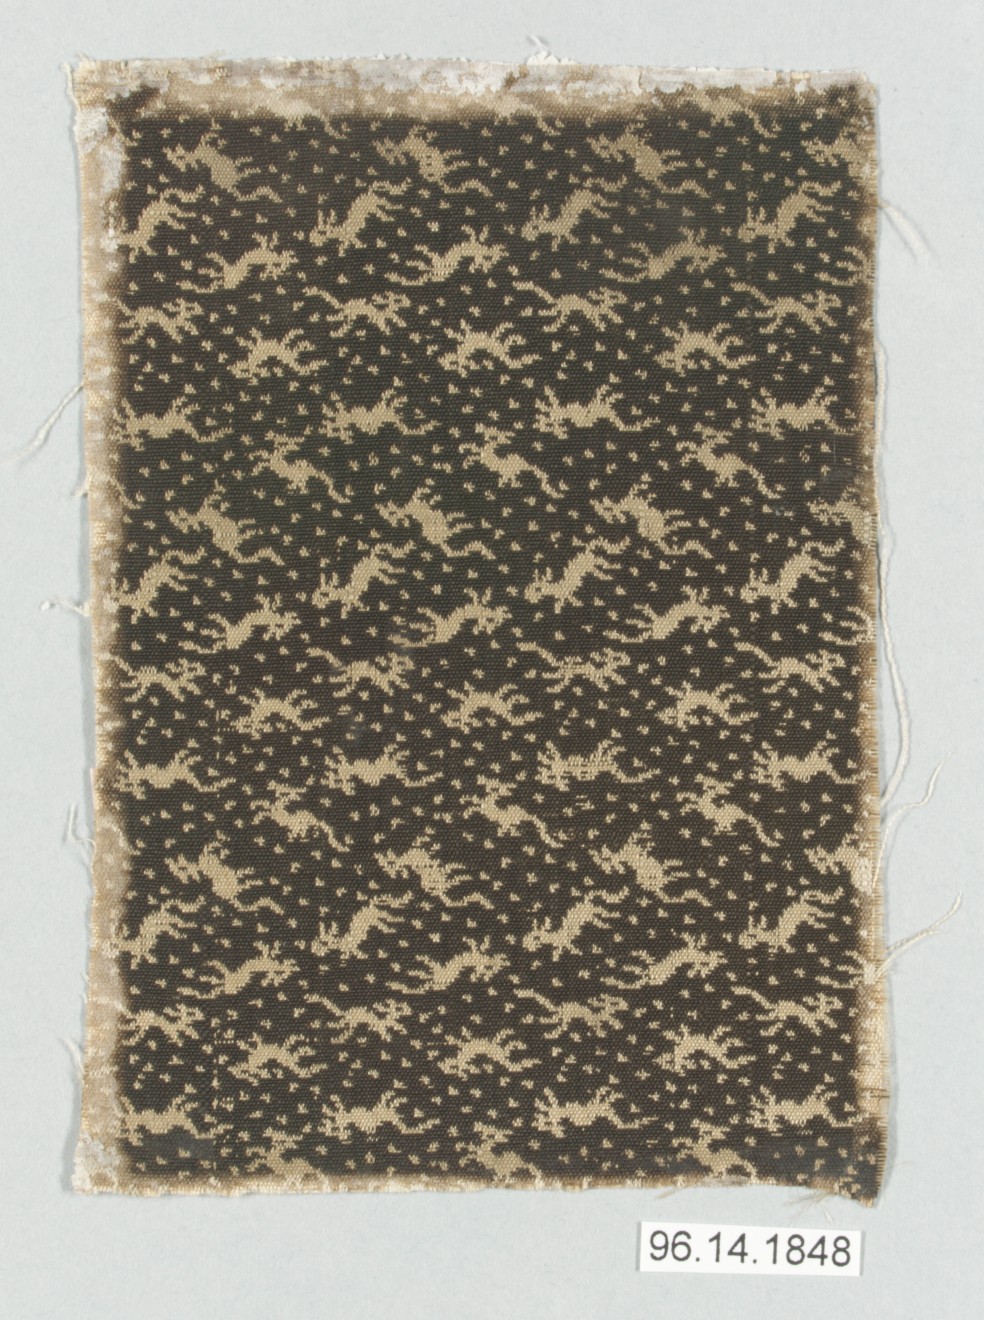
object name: piece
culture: japanese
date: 1801-1900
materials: silk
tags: animals